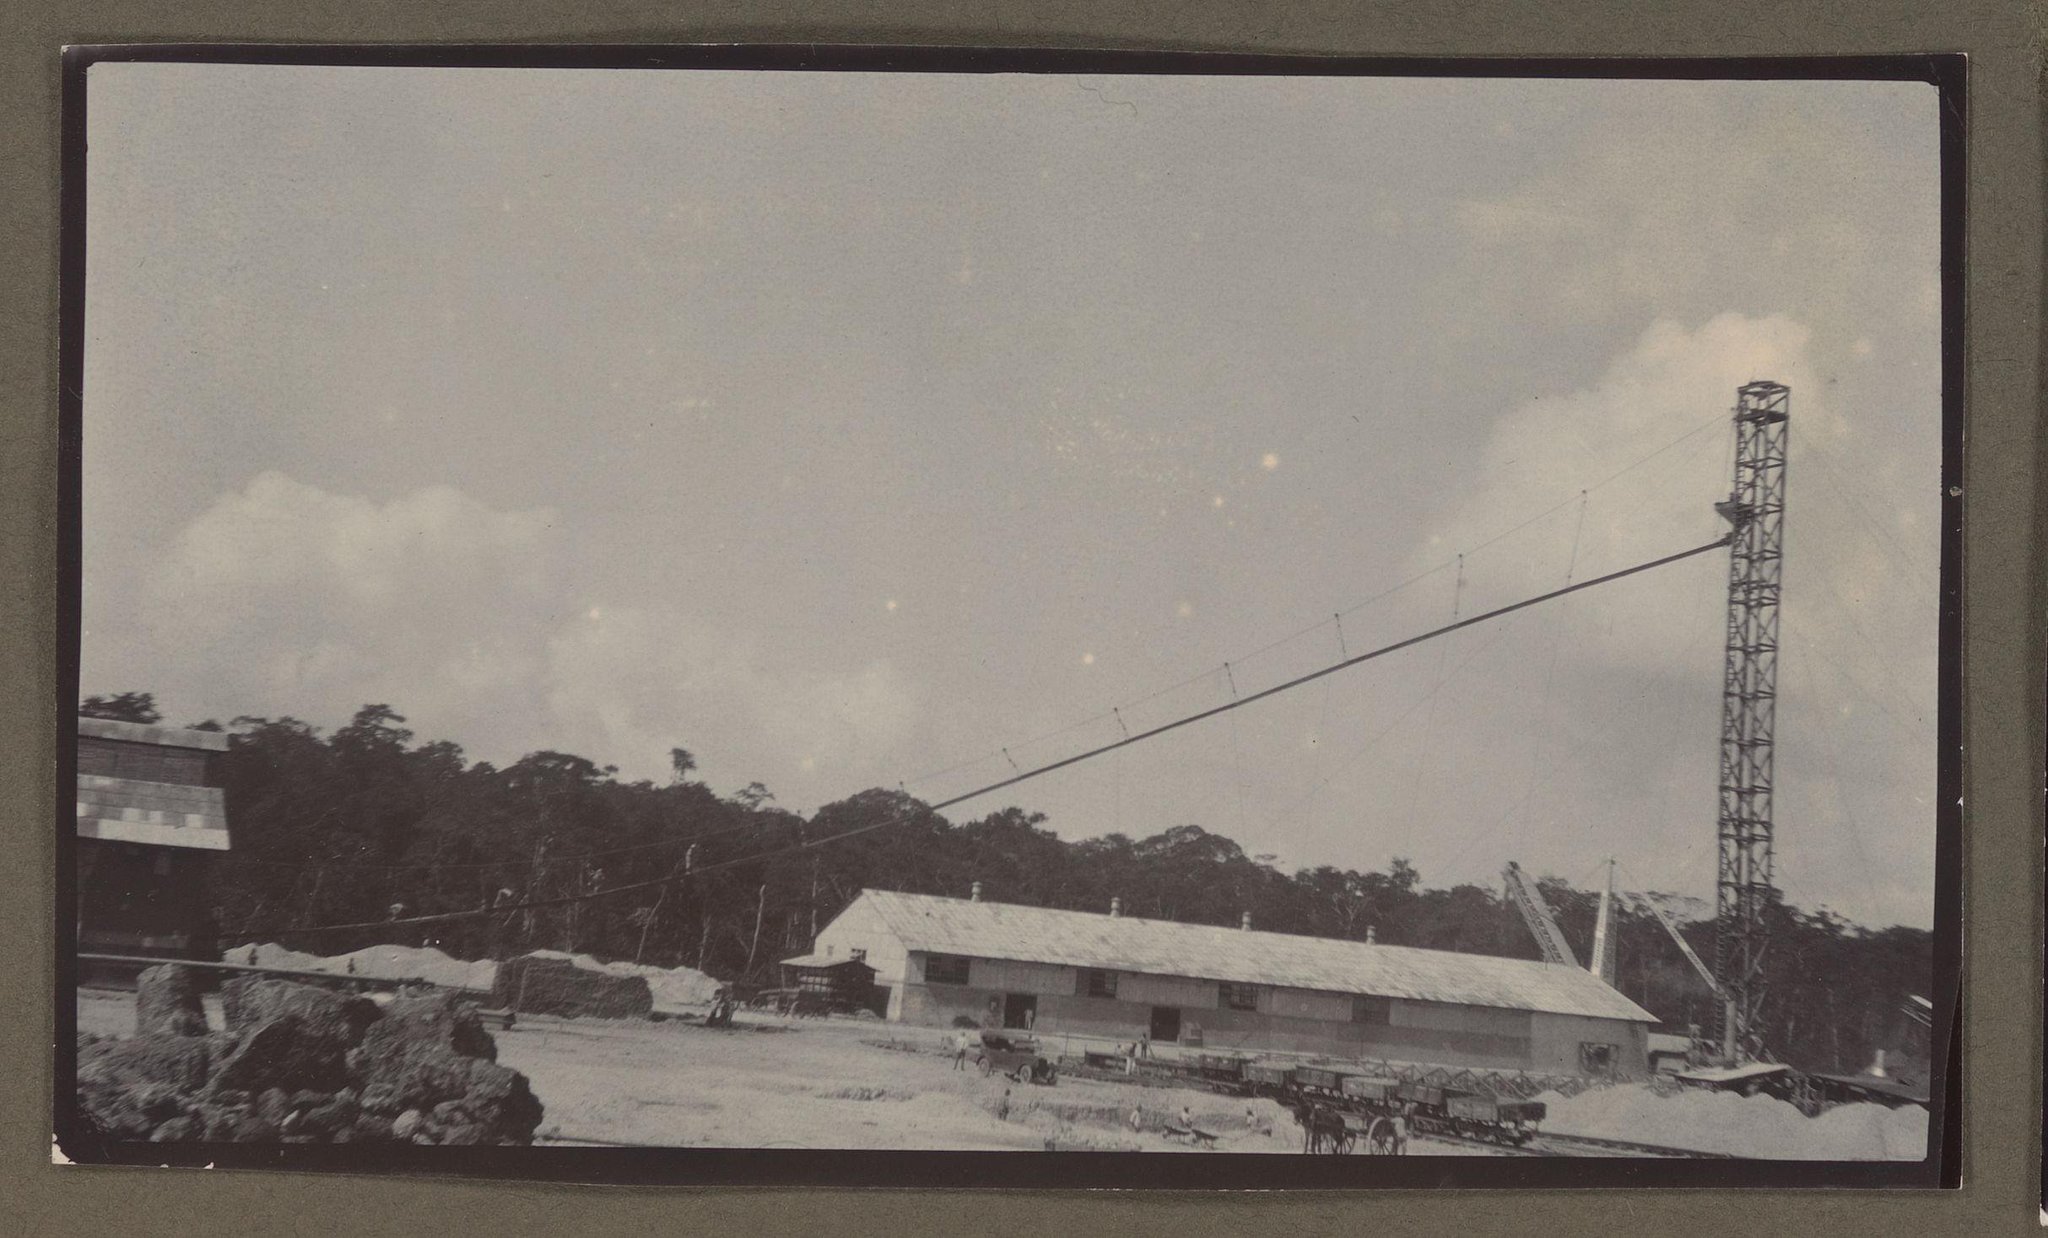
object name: photograph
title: Mijn en fabriek te Moengo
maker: Anonymous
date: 1925-1927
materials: photographic support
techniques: photography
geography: suriname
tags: jetten, familie, moengo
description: Het terrein van de mijn en fabriek te Moengo. Foto op een bladzijde van een los albumblad. Onderdeel van het ensemble met foto's van de familie van ingenieur Jetten in de mijnbouwstad Moengo in Suriname.